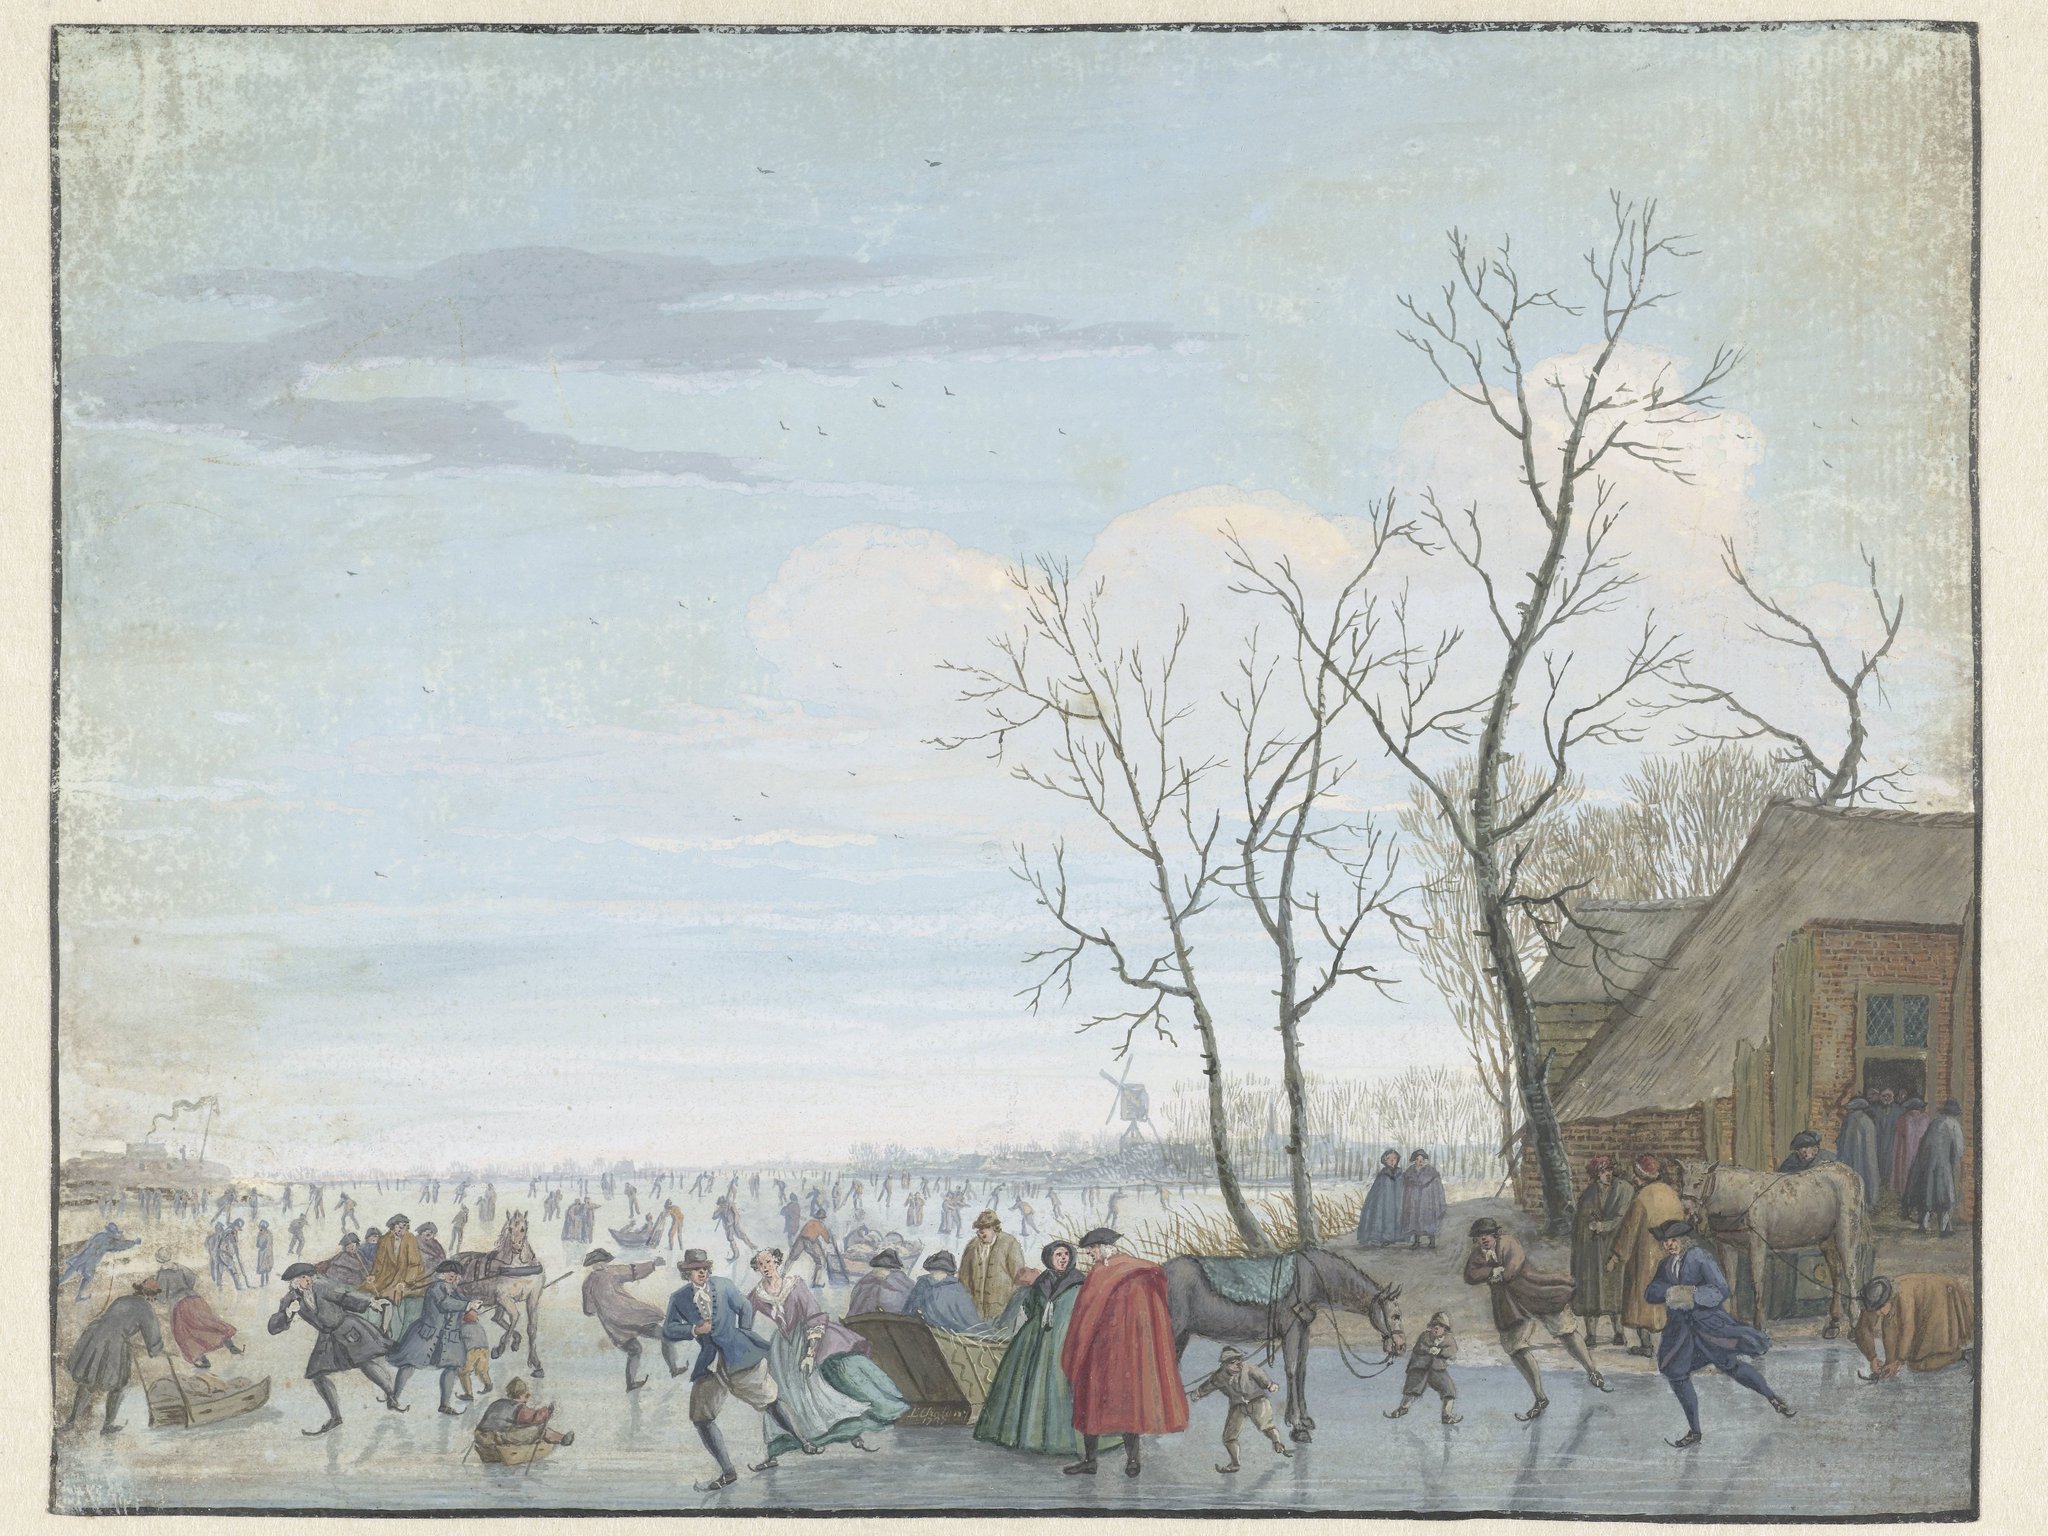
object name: drawing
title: Winterlandschap met ijsvermaak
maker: louis chalon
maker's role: draughtsman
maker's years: 1687-1741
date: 1697-1741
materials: paint, gouache, paper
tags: winter sports, ice ~ freezing weather